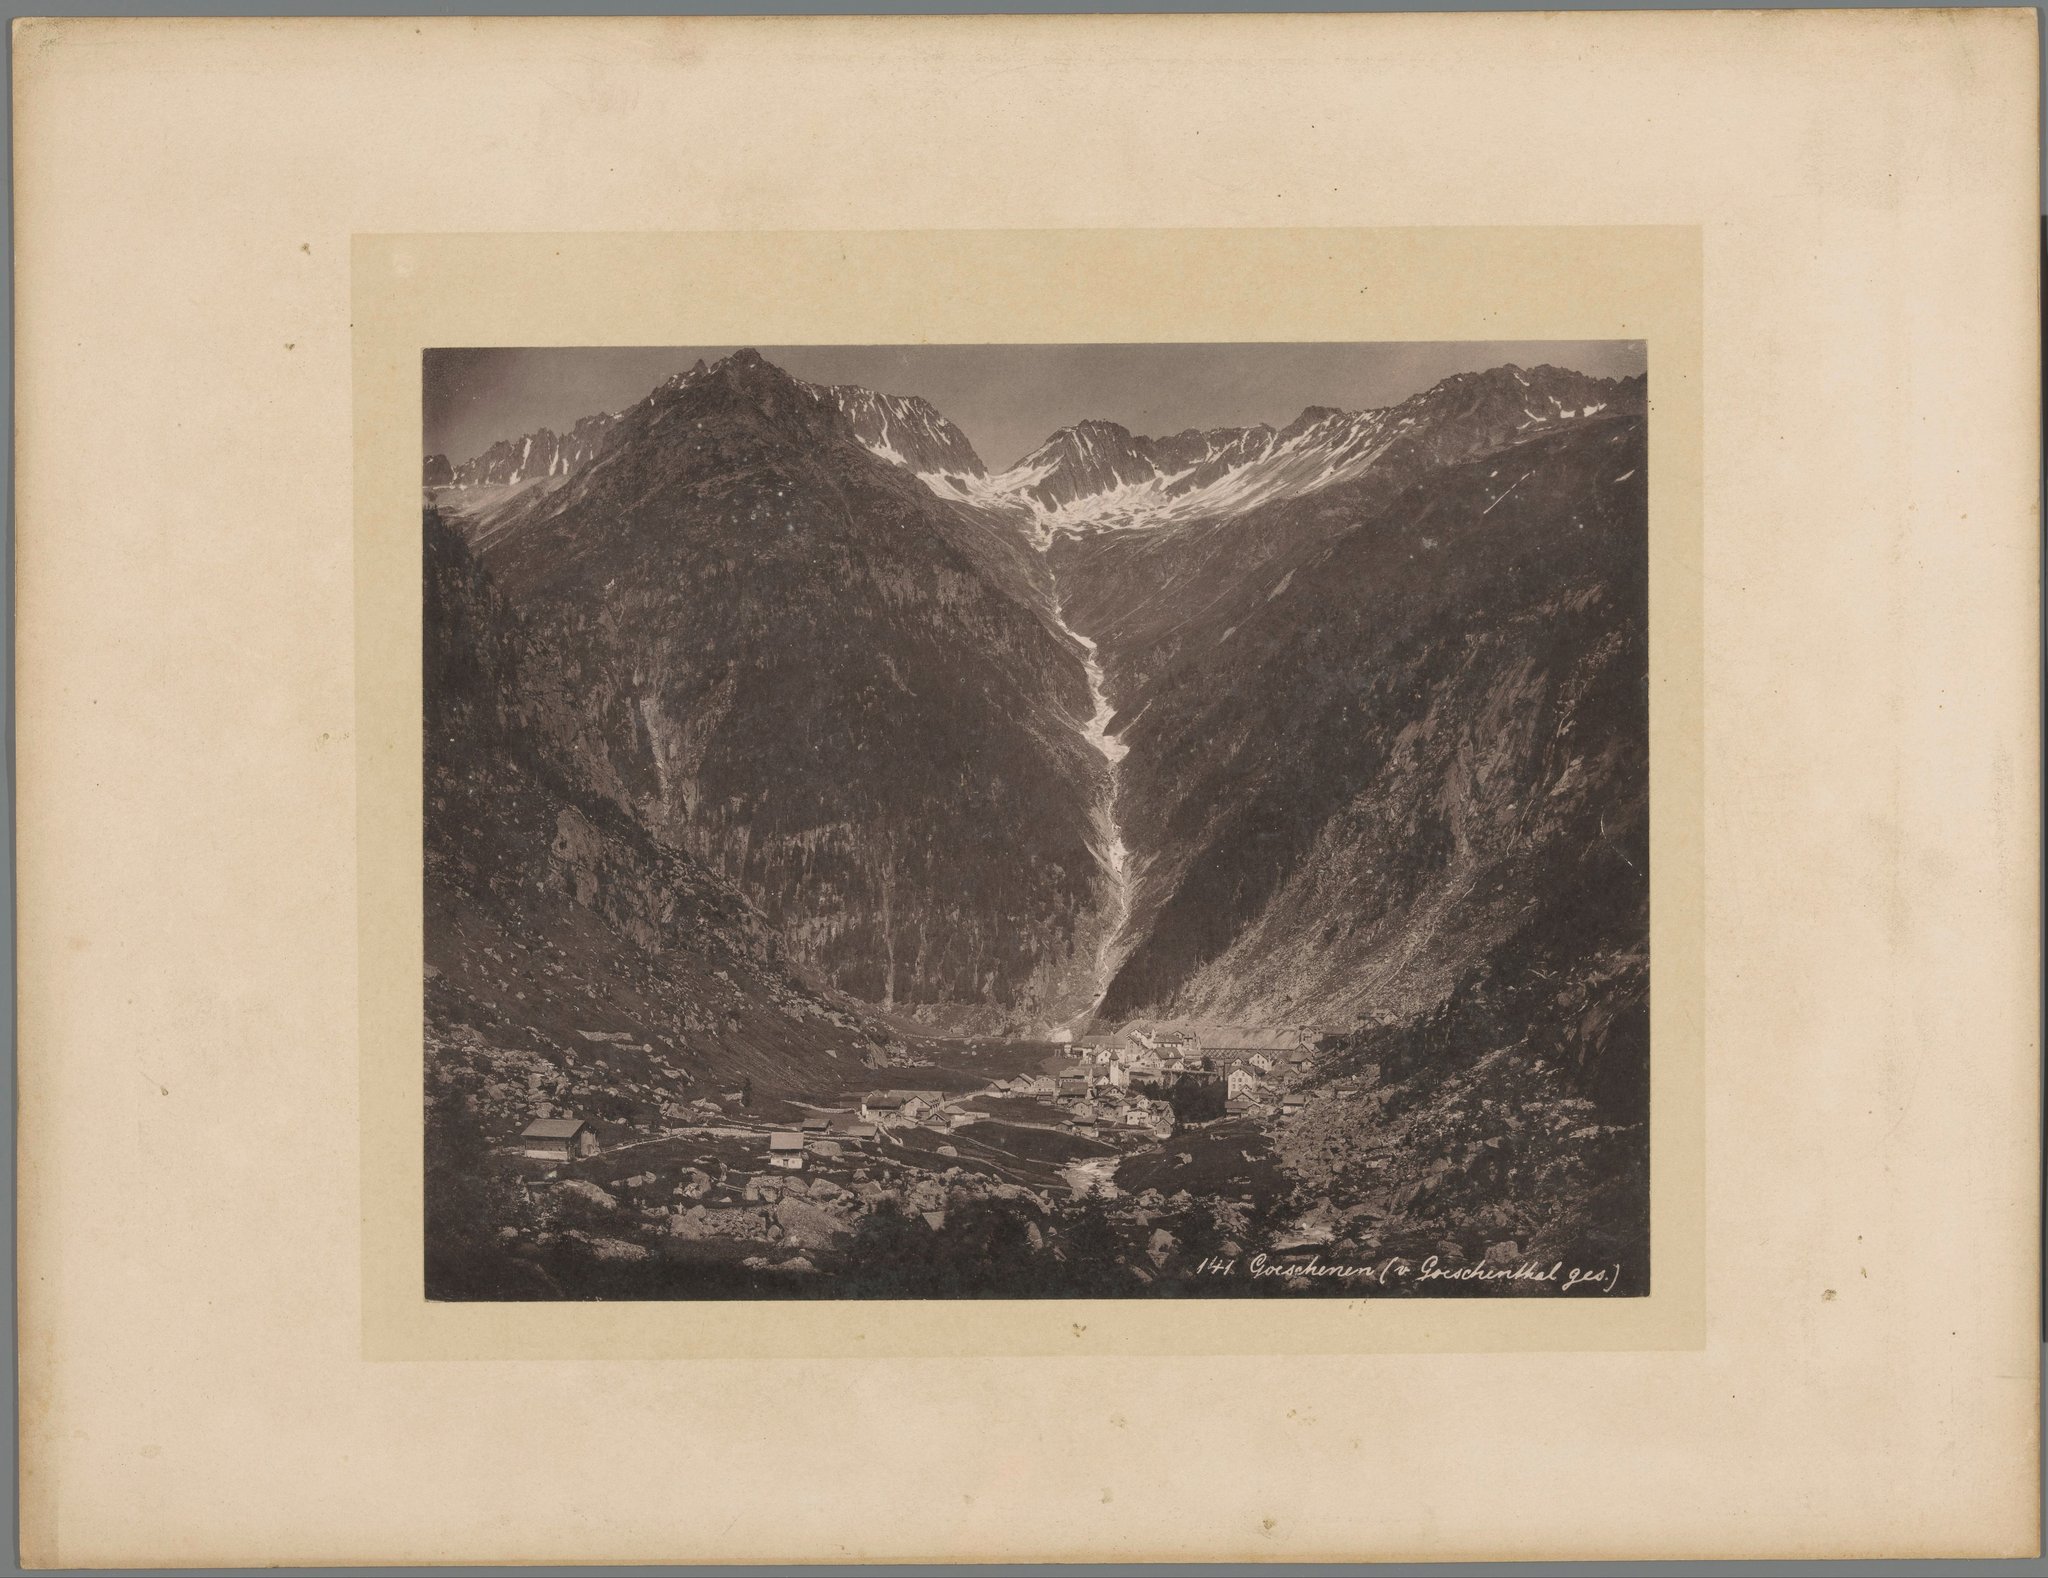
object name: photomechanical print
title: Goeschenen (v. Goeschenthal ges.)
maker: Anonymous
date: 1870-1930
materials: cardboard, paper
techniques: photograph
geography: göschenen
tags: dale, valley, village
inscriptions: number: ‘141.’